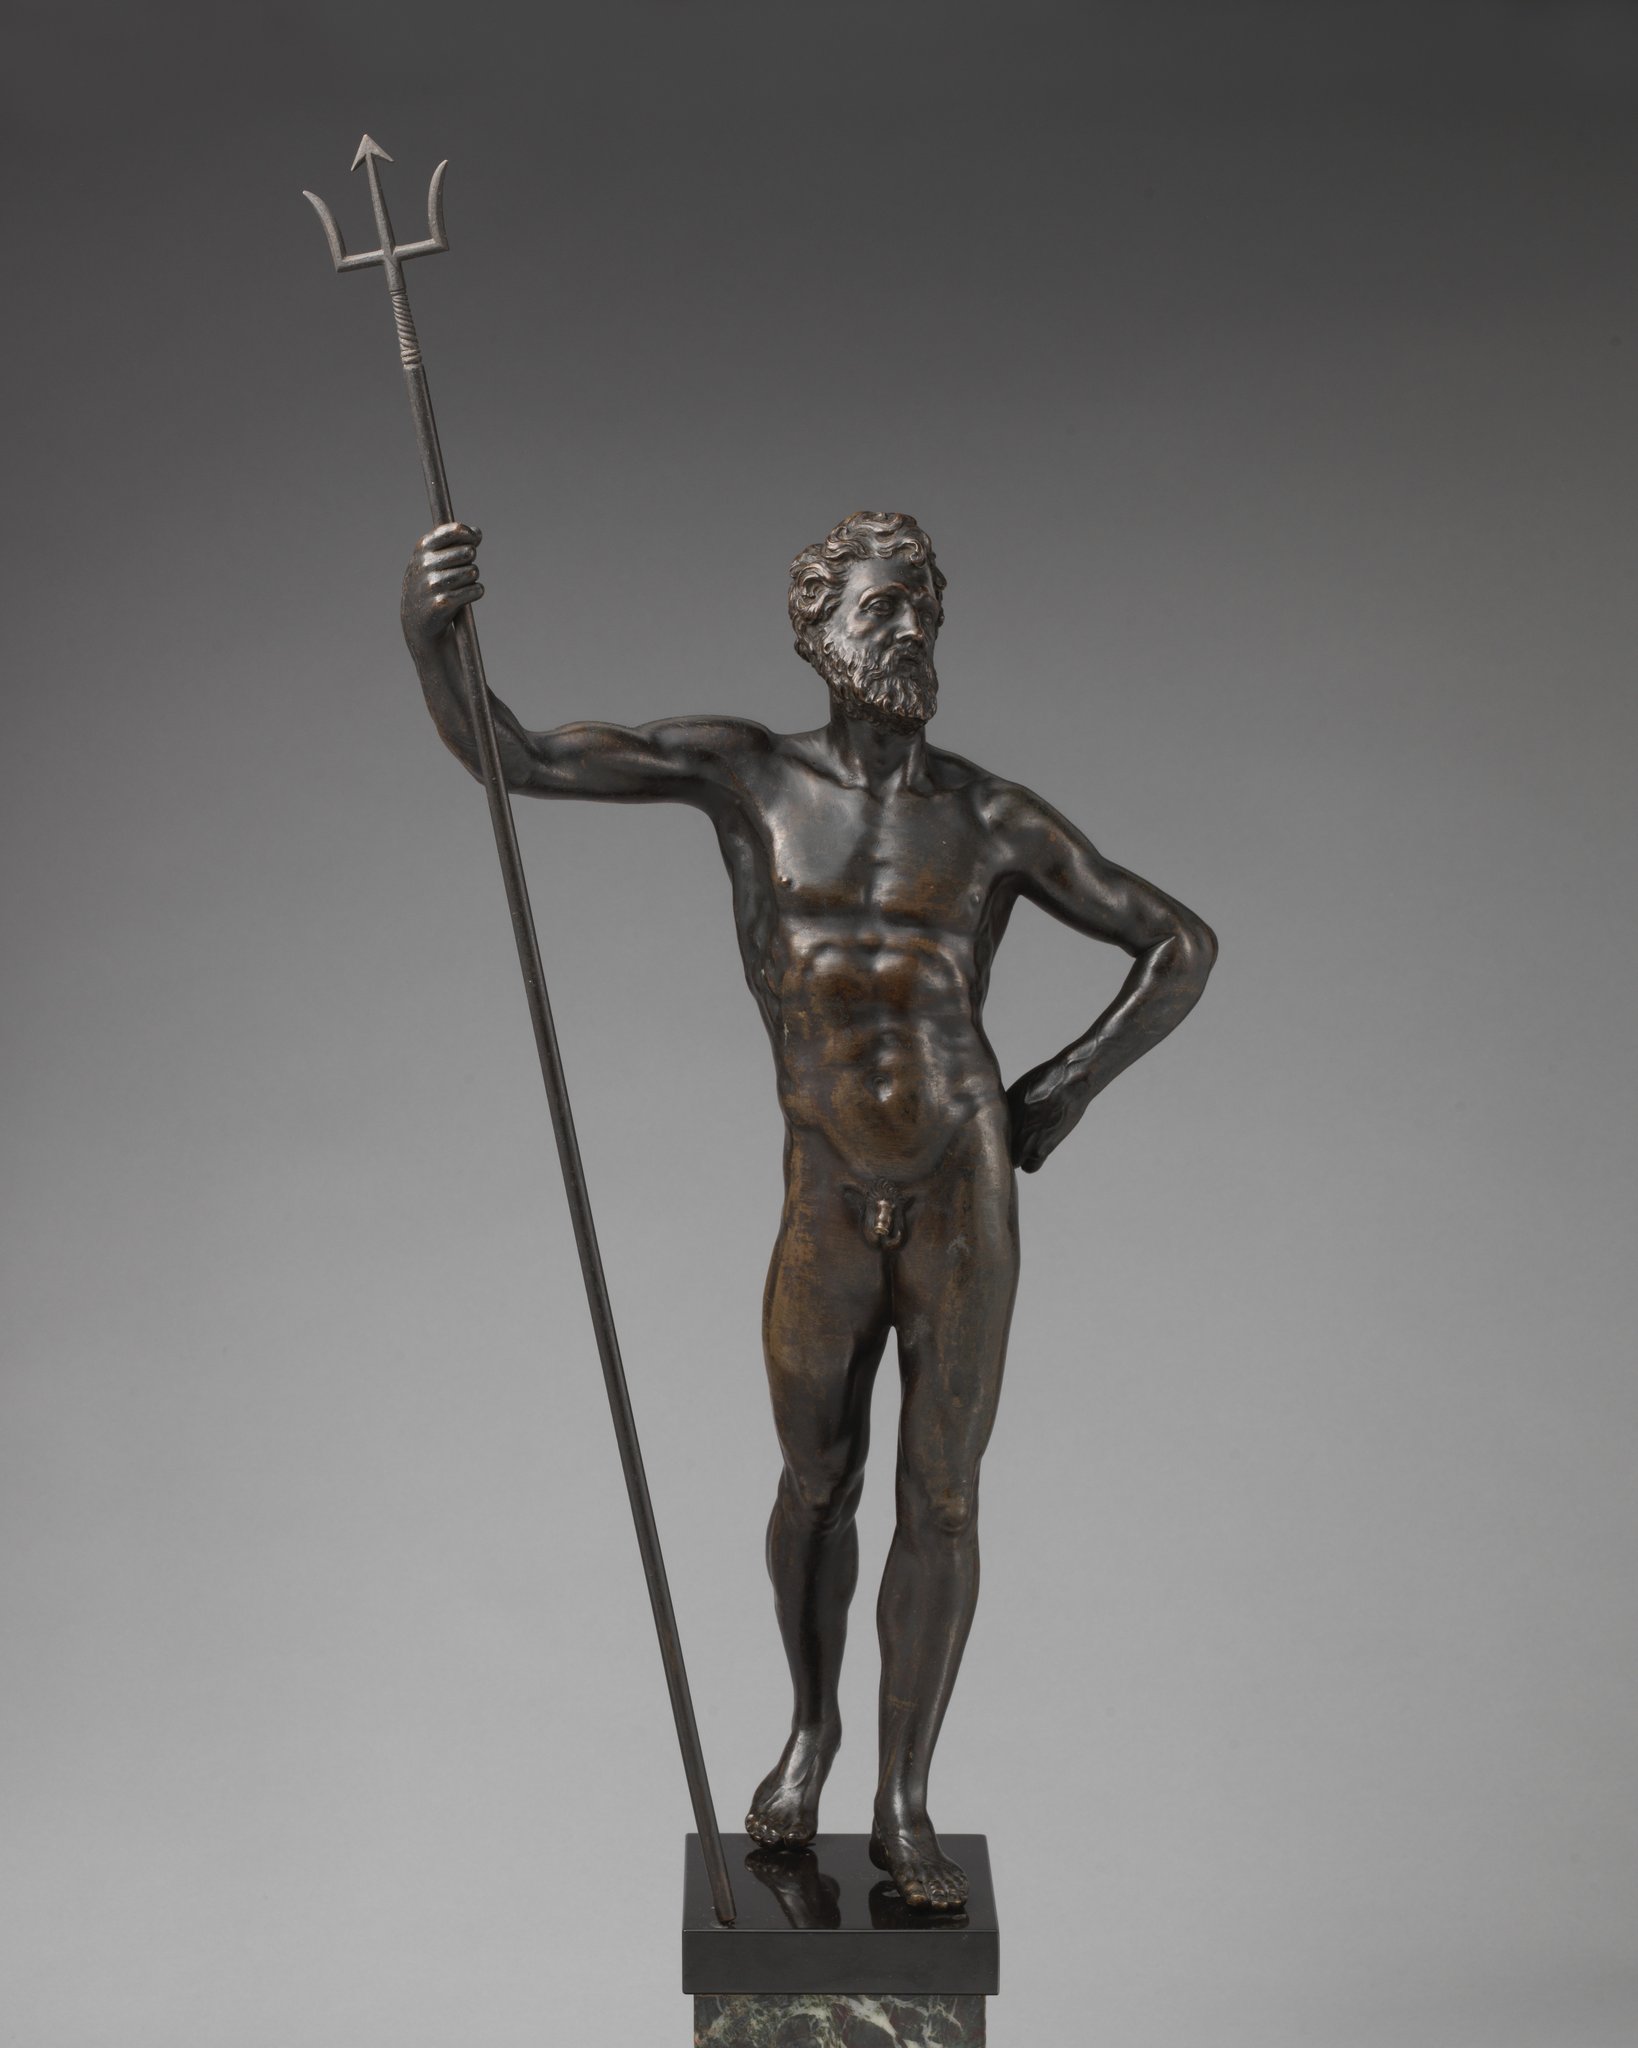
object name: statuette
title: Neptune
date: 1501-1600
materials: bronze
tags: neptune